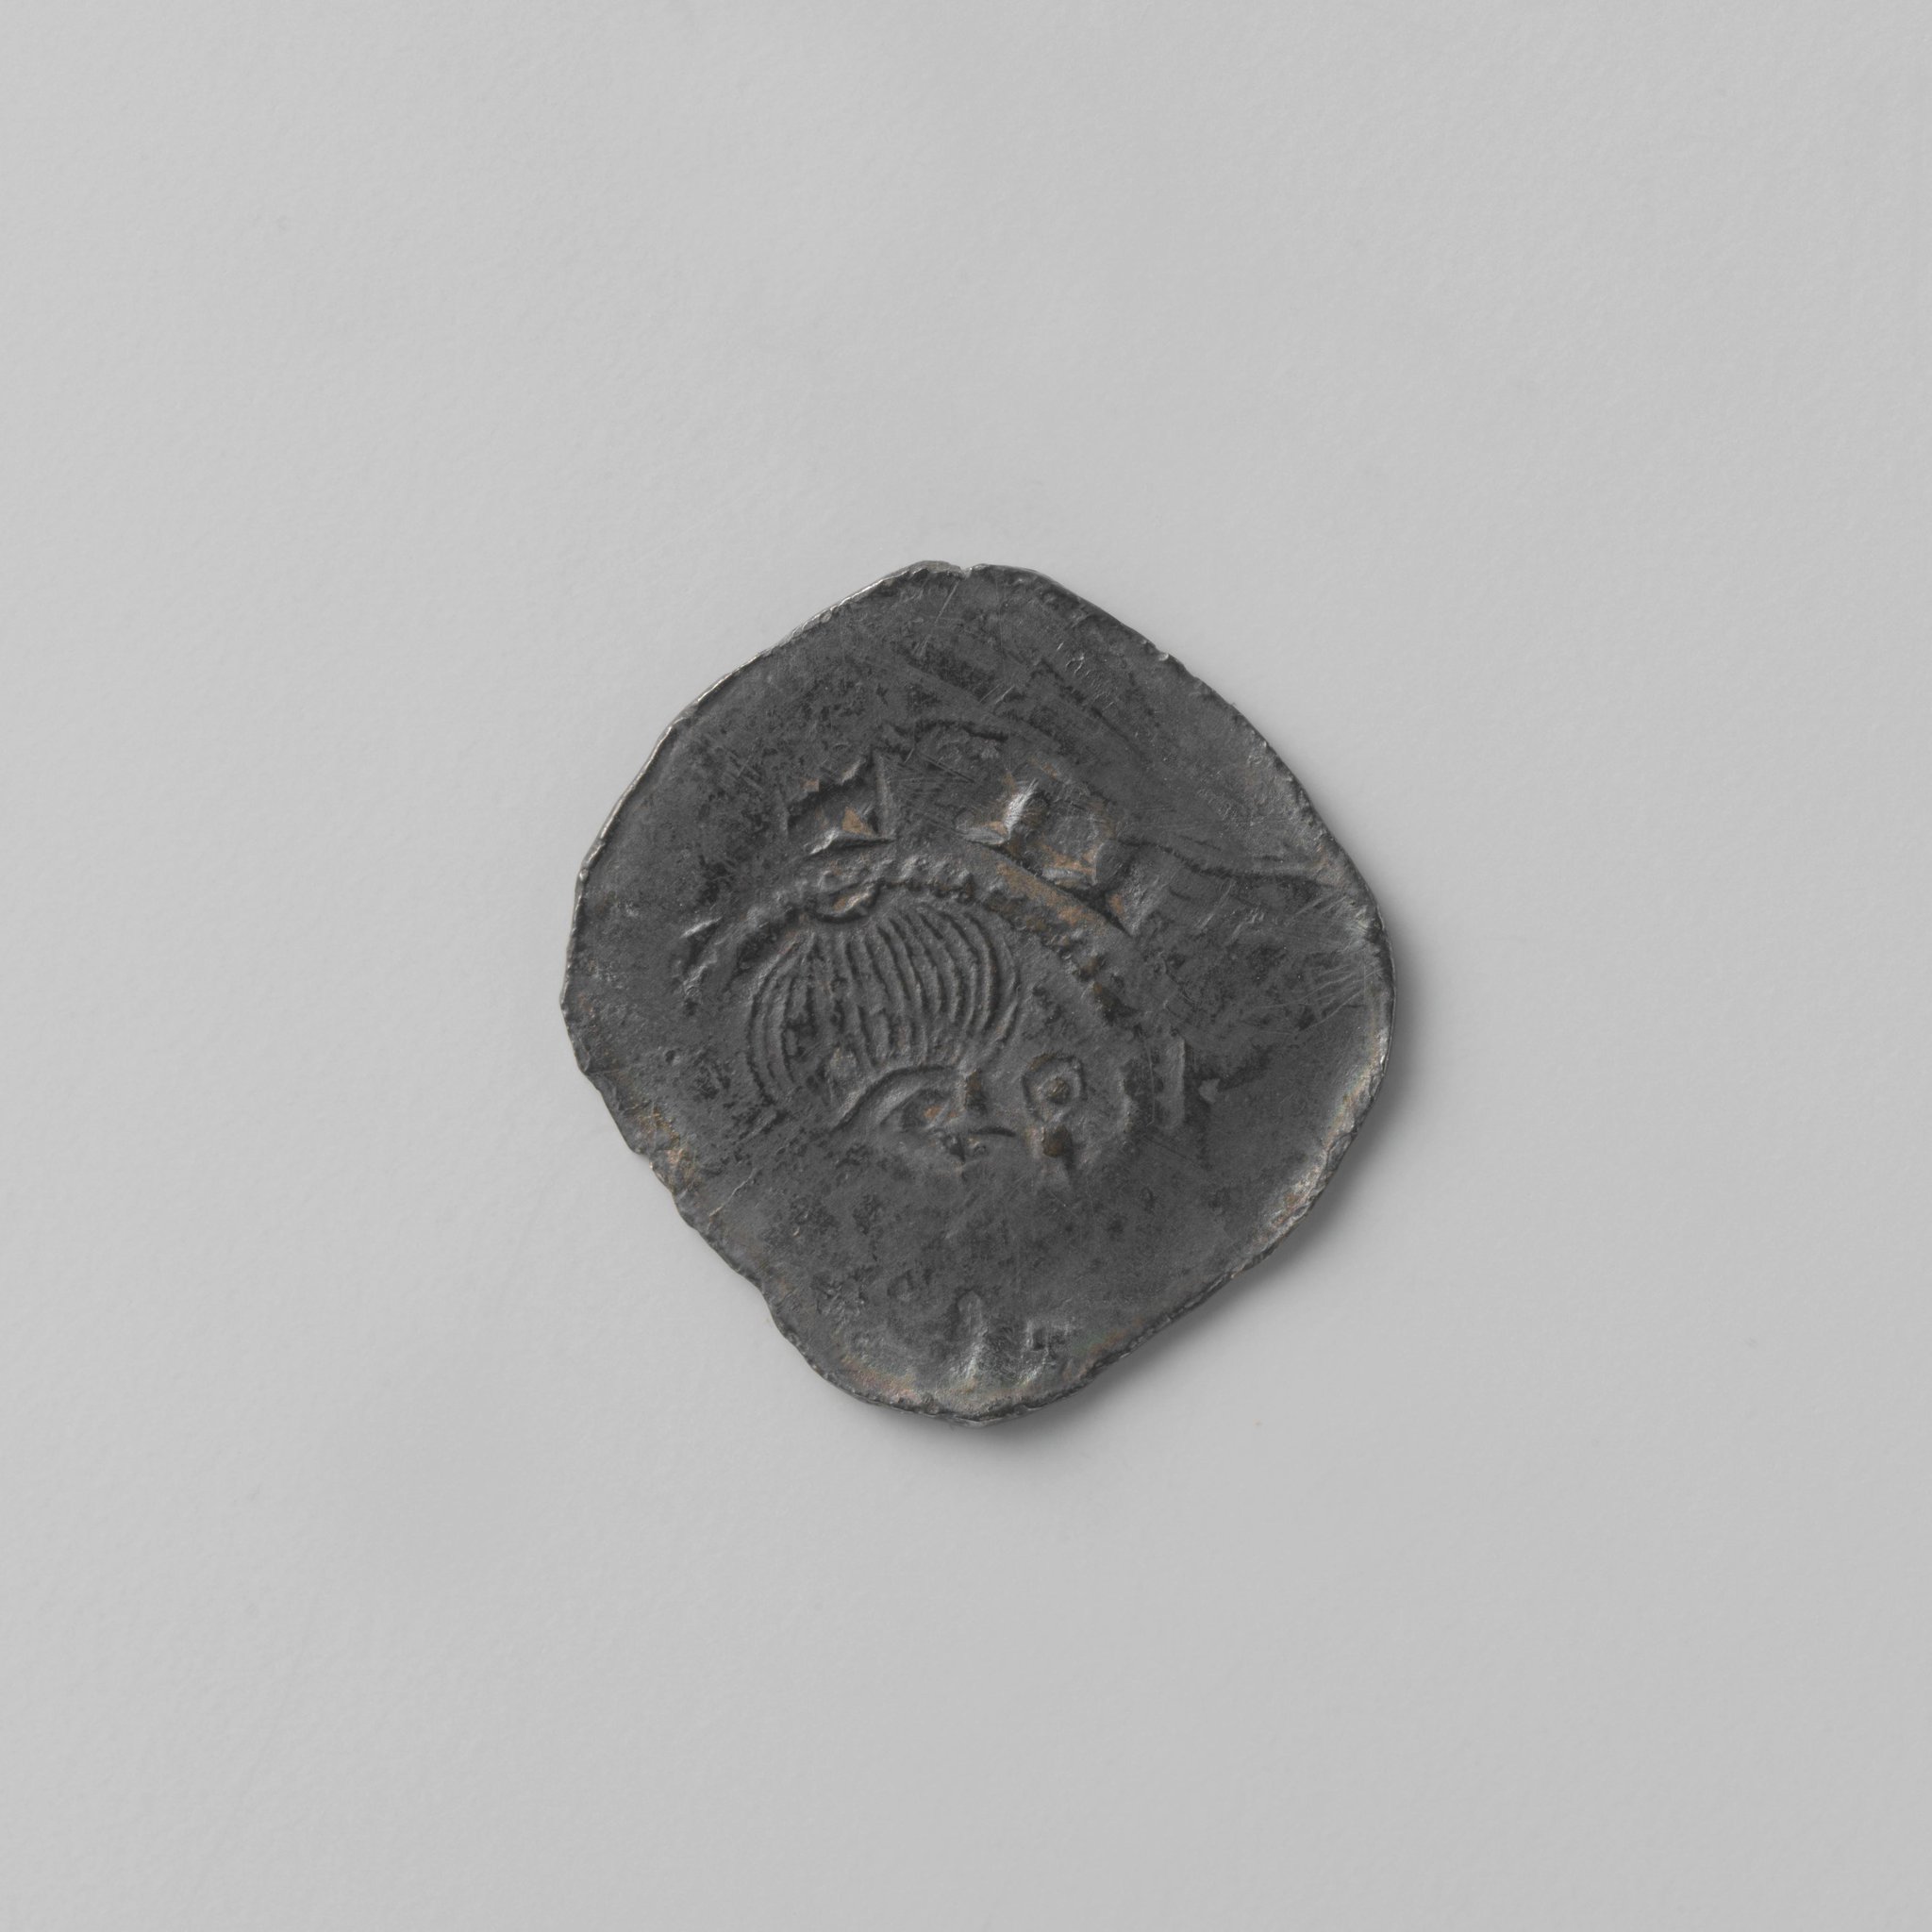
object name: coin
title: Utrecht, Herman van Hoorne, penning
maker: herman van horne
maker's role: bisschop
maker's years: -1156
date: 1150-1156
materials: silver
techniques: striking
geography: utrecht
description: Zilveren munt. Voorzijde: portret van de bisschop met tonsuur naar rechts met voor zich bisschopsstaf. Keerzijde: kort gevoet kruis, op uiteinden stippen, in hart cirkel, waarin sterretje.